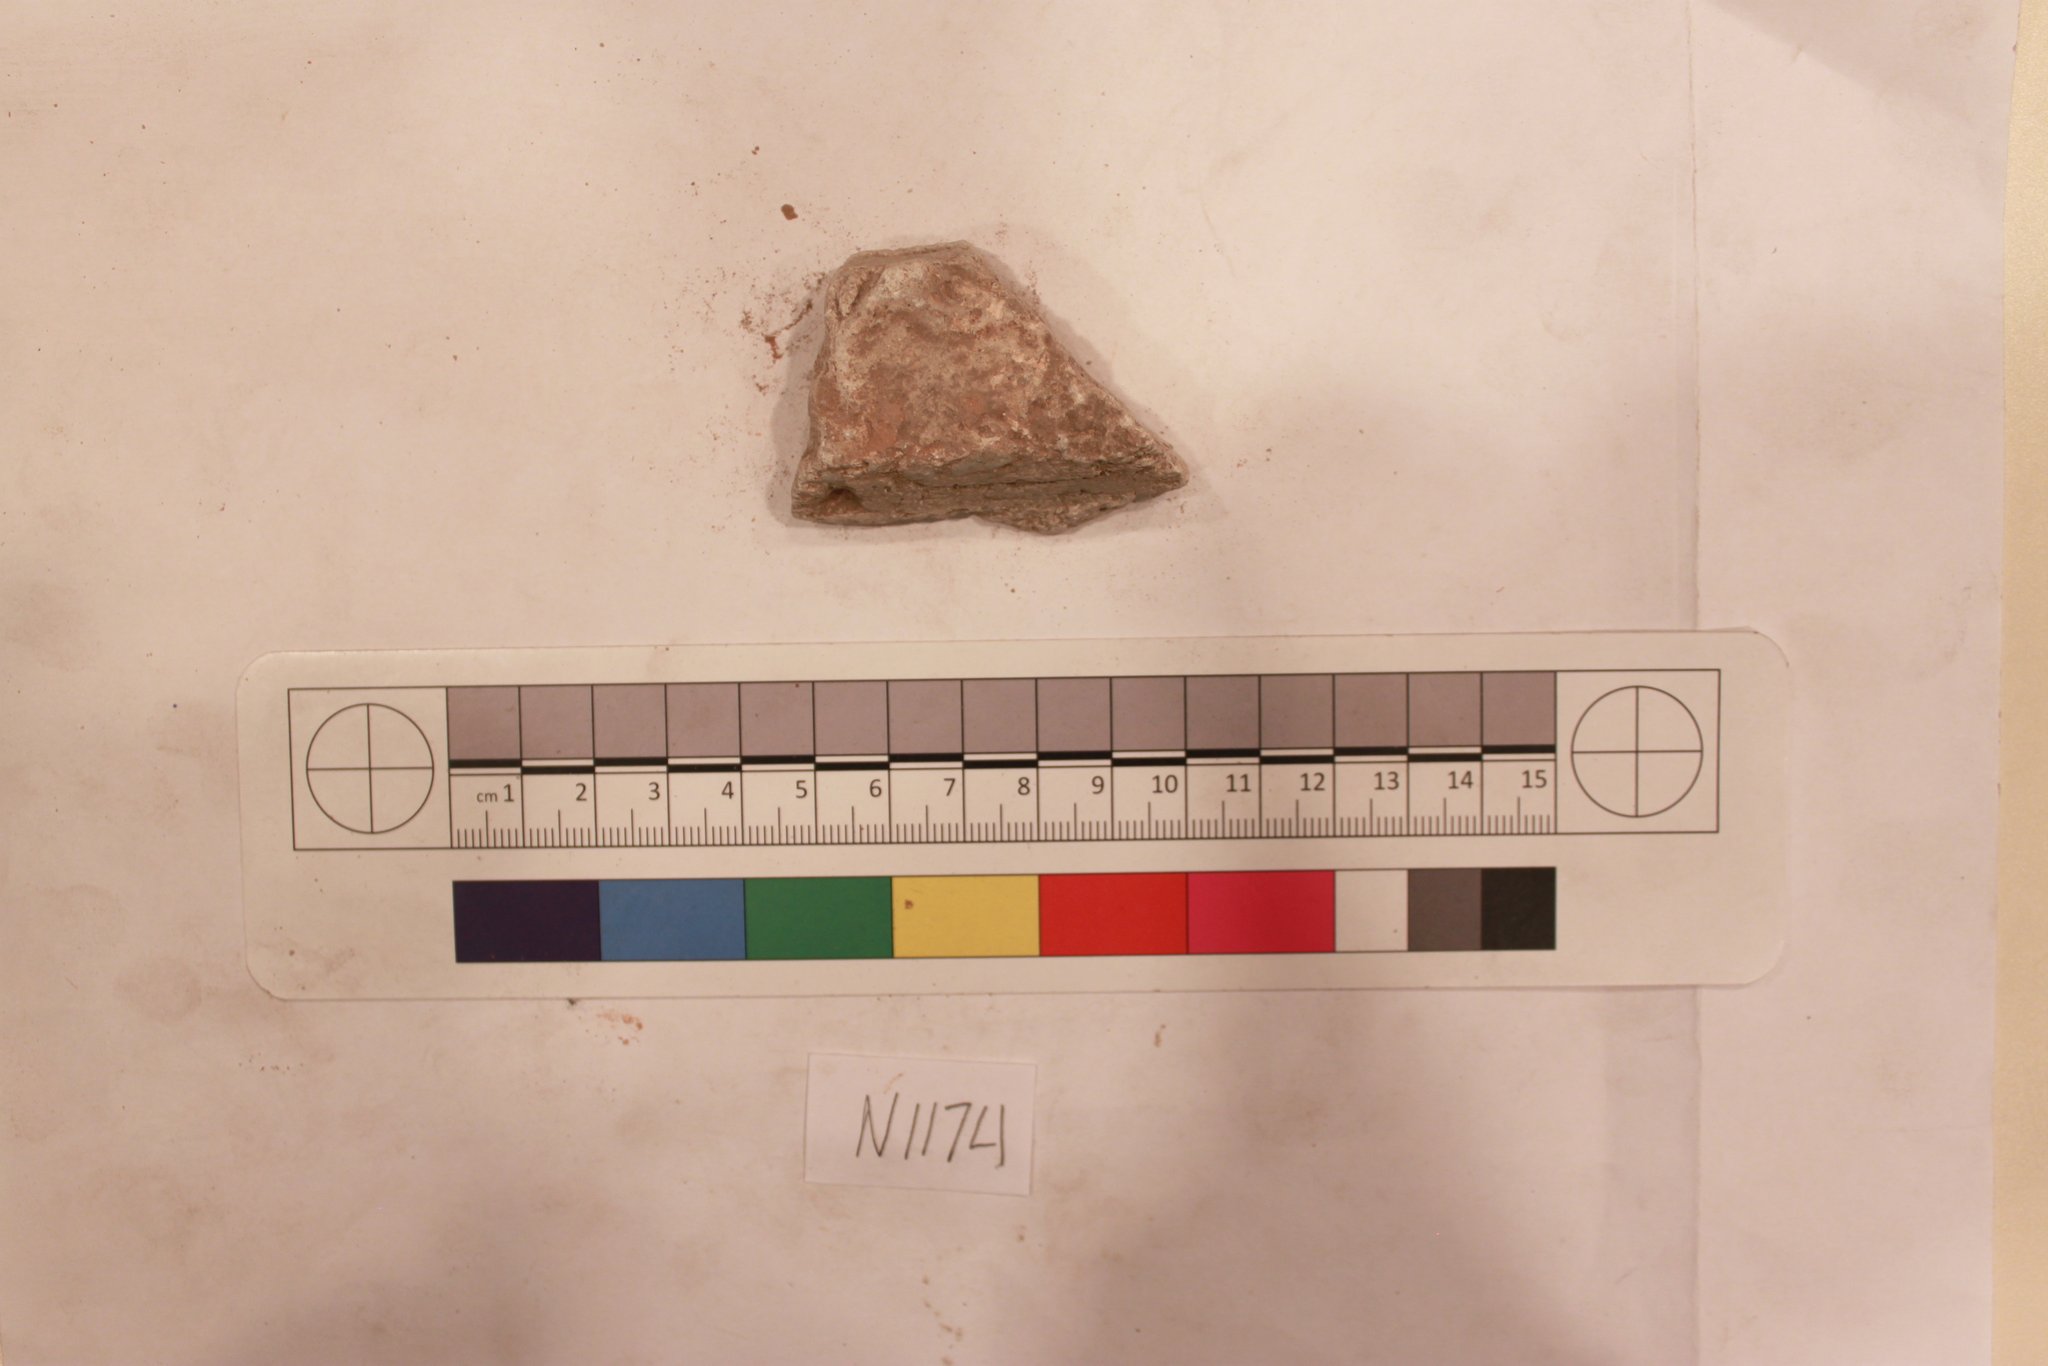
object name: fragment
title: Stucco Fragment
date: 701-1200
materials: plaster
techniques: carving, painting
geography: iran